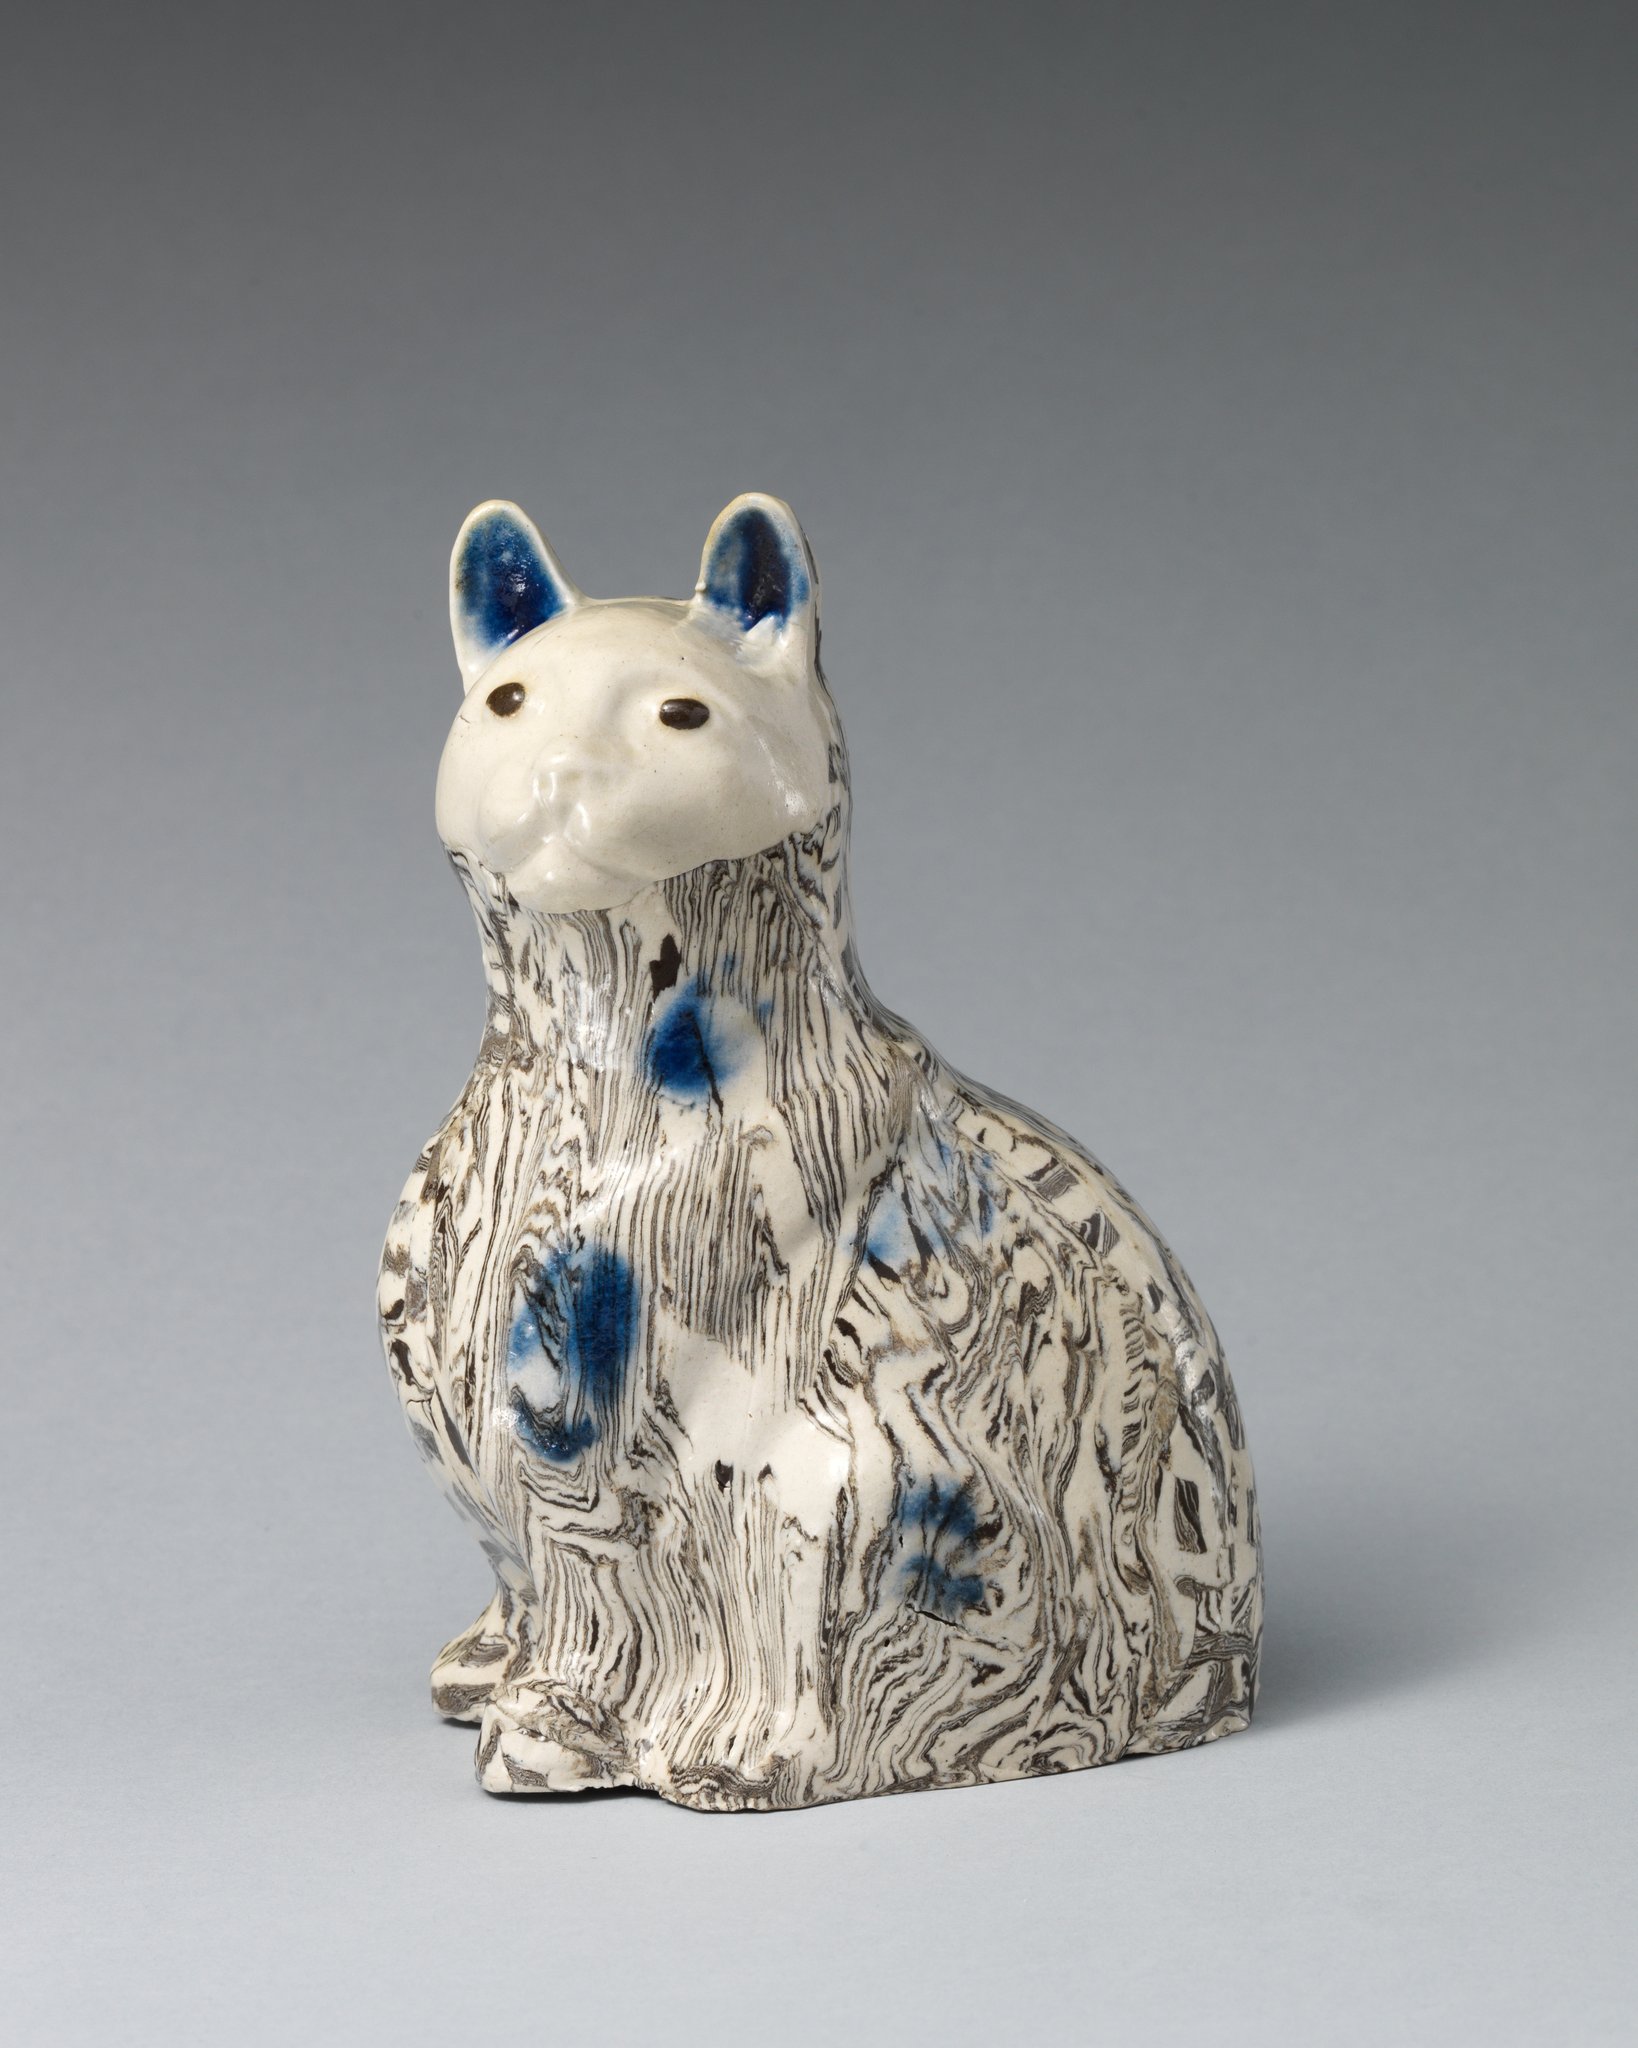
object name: figure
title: Cat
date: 1745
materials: stoneware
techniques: salt glaze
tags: cats